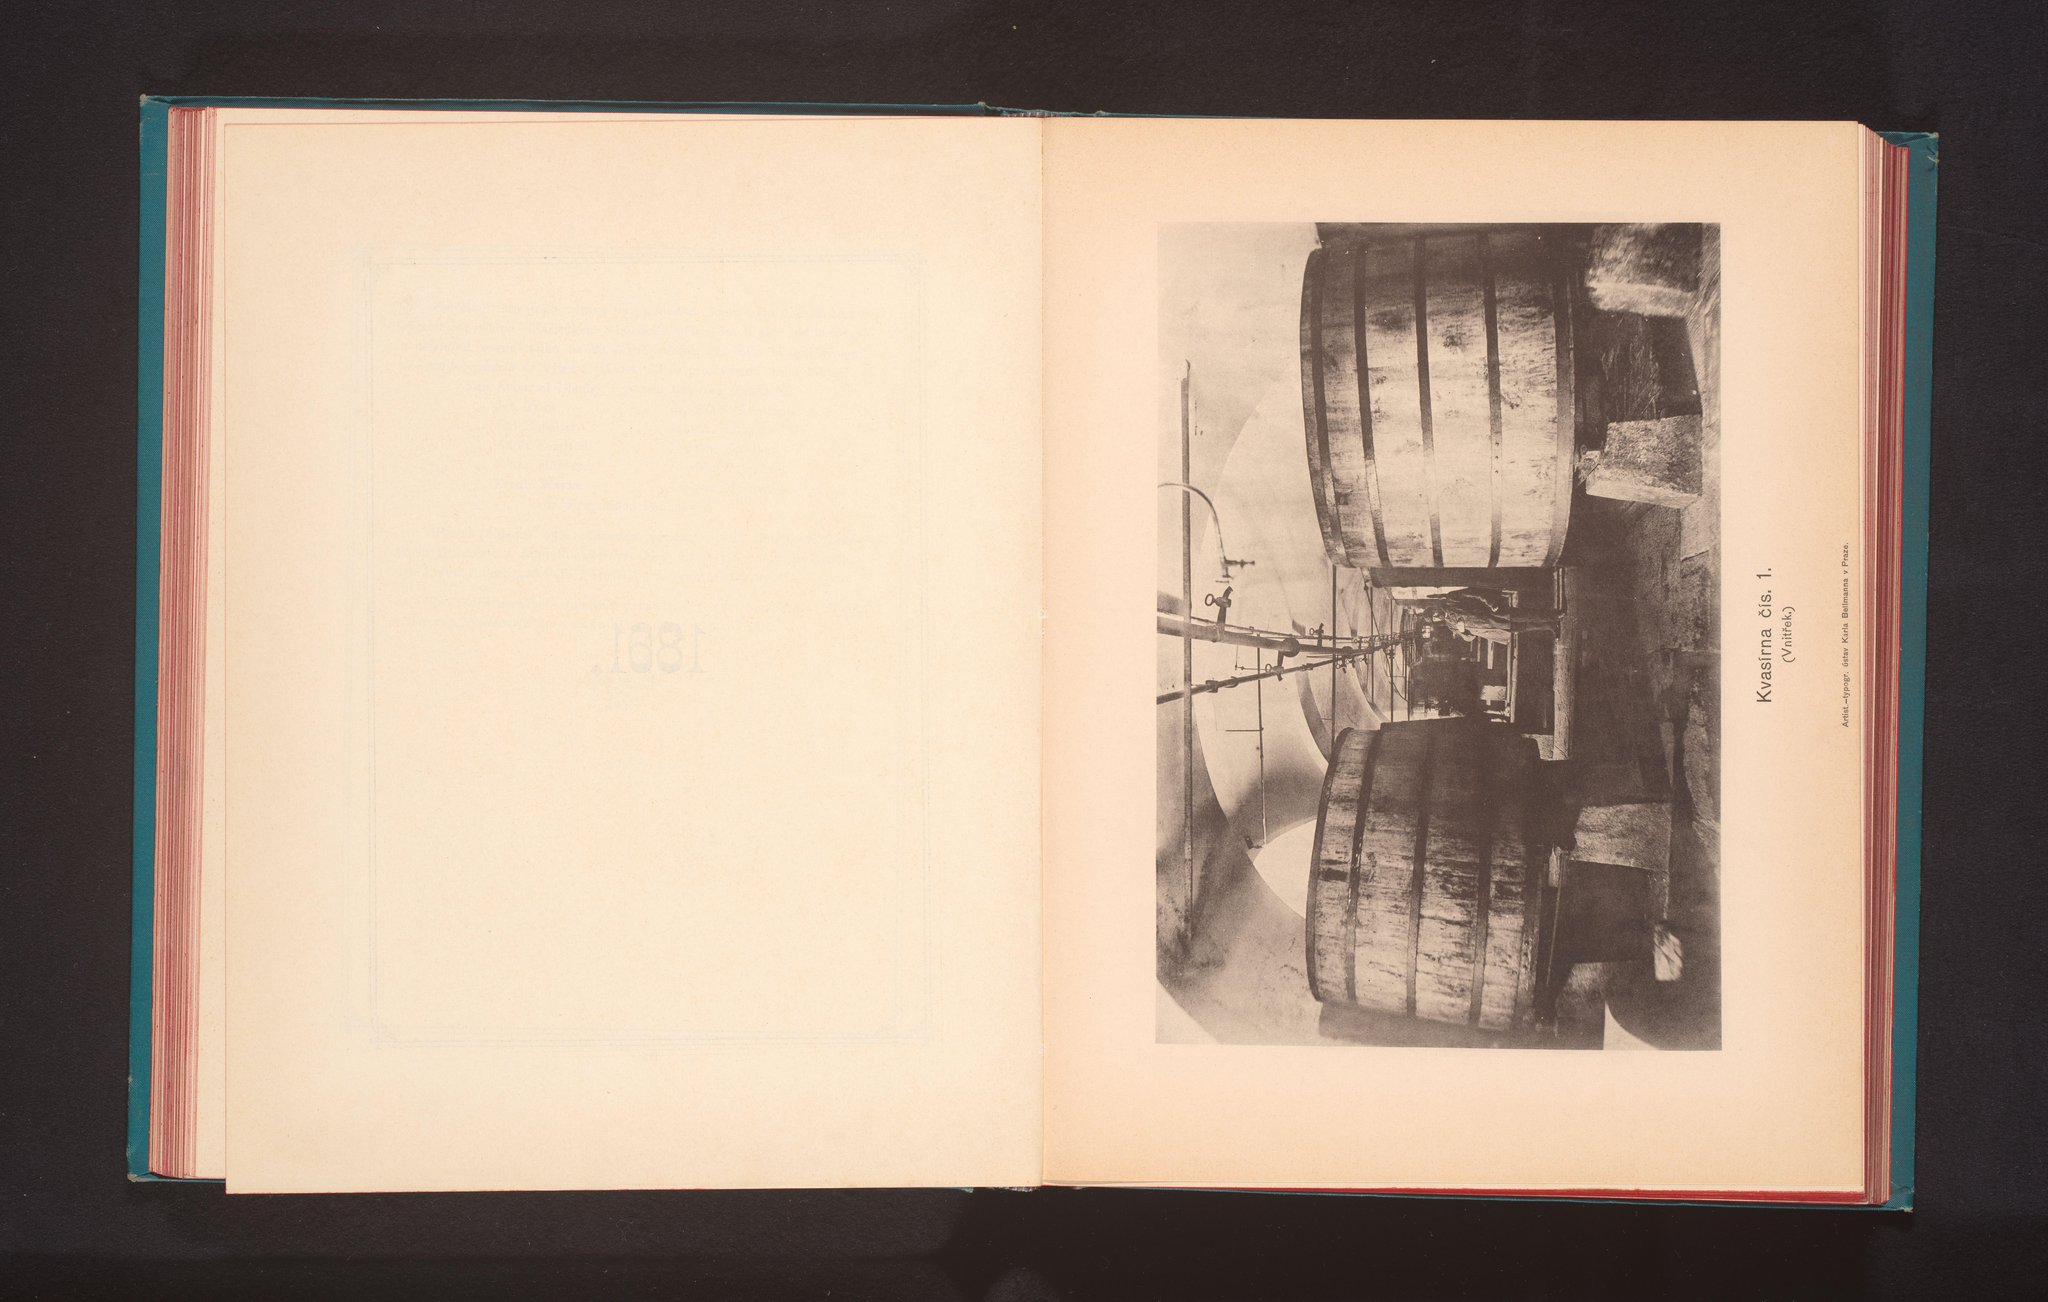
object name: photomechanical print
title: Ruimte met biervaten van de brouwerij Plzeňský Prazdroj te Plzeň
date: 1882-1892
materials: paper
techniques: photograph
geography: prague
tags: brewer, wooden container: barrel, cask, bucket